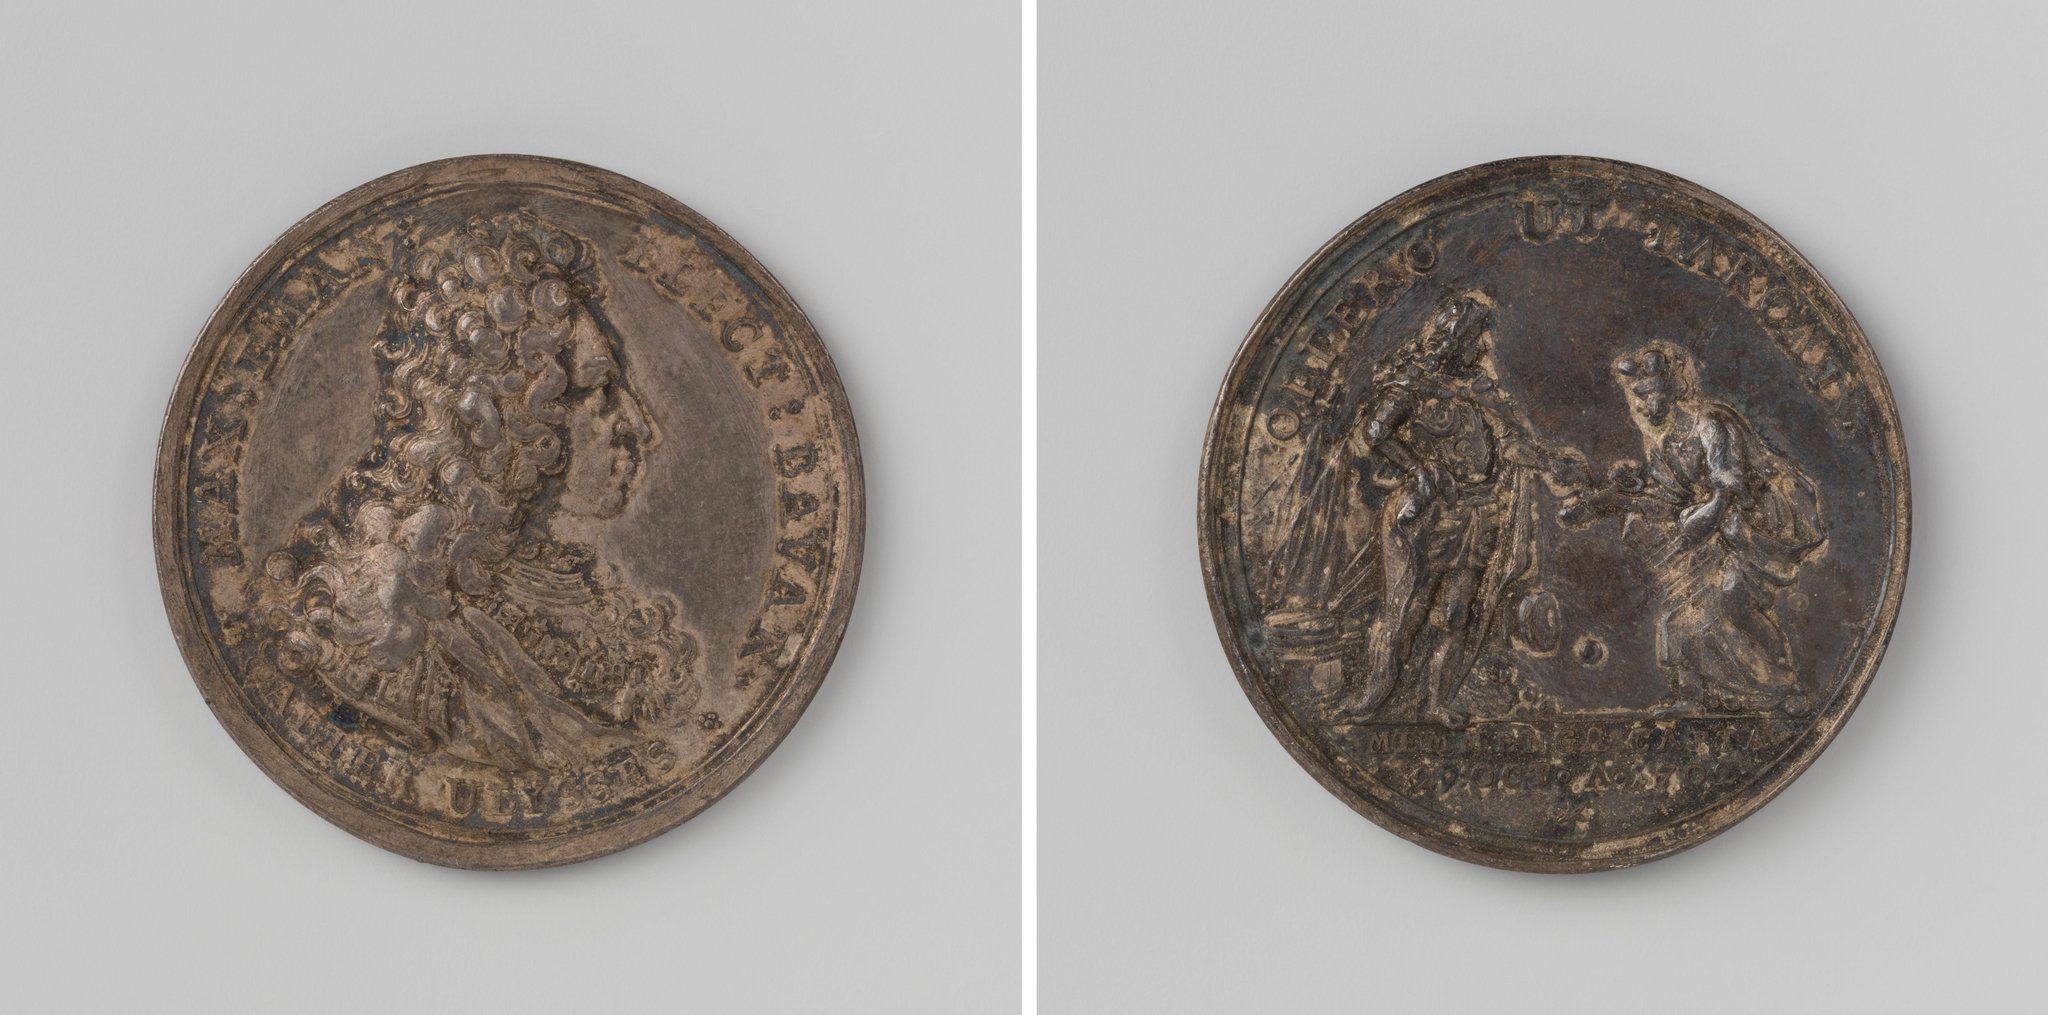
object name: history medal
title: Inname van Memingen door Maximiliaan II Emanuel, keurvorst van Beieren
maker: philipp heinrich müller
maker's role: medailleur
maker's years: 1654-1719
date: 1702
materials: silver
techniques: striking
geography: nuremberg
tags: maximiliaan ii emanuel (keurvorst van beieren)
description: Zilveren penning. Voorzijde: borststuk man binnen omschrift. Keerzijde: Memingen in gedaante van vrouw met kroon bukt voor keurvorst van Beieren om hem sleutels van stad aan te bieden binnen omschrift, boven opschrift